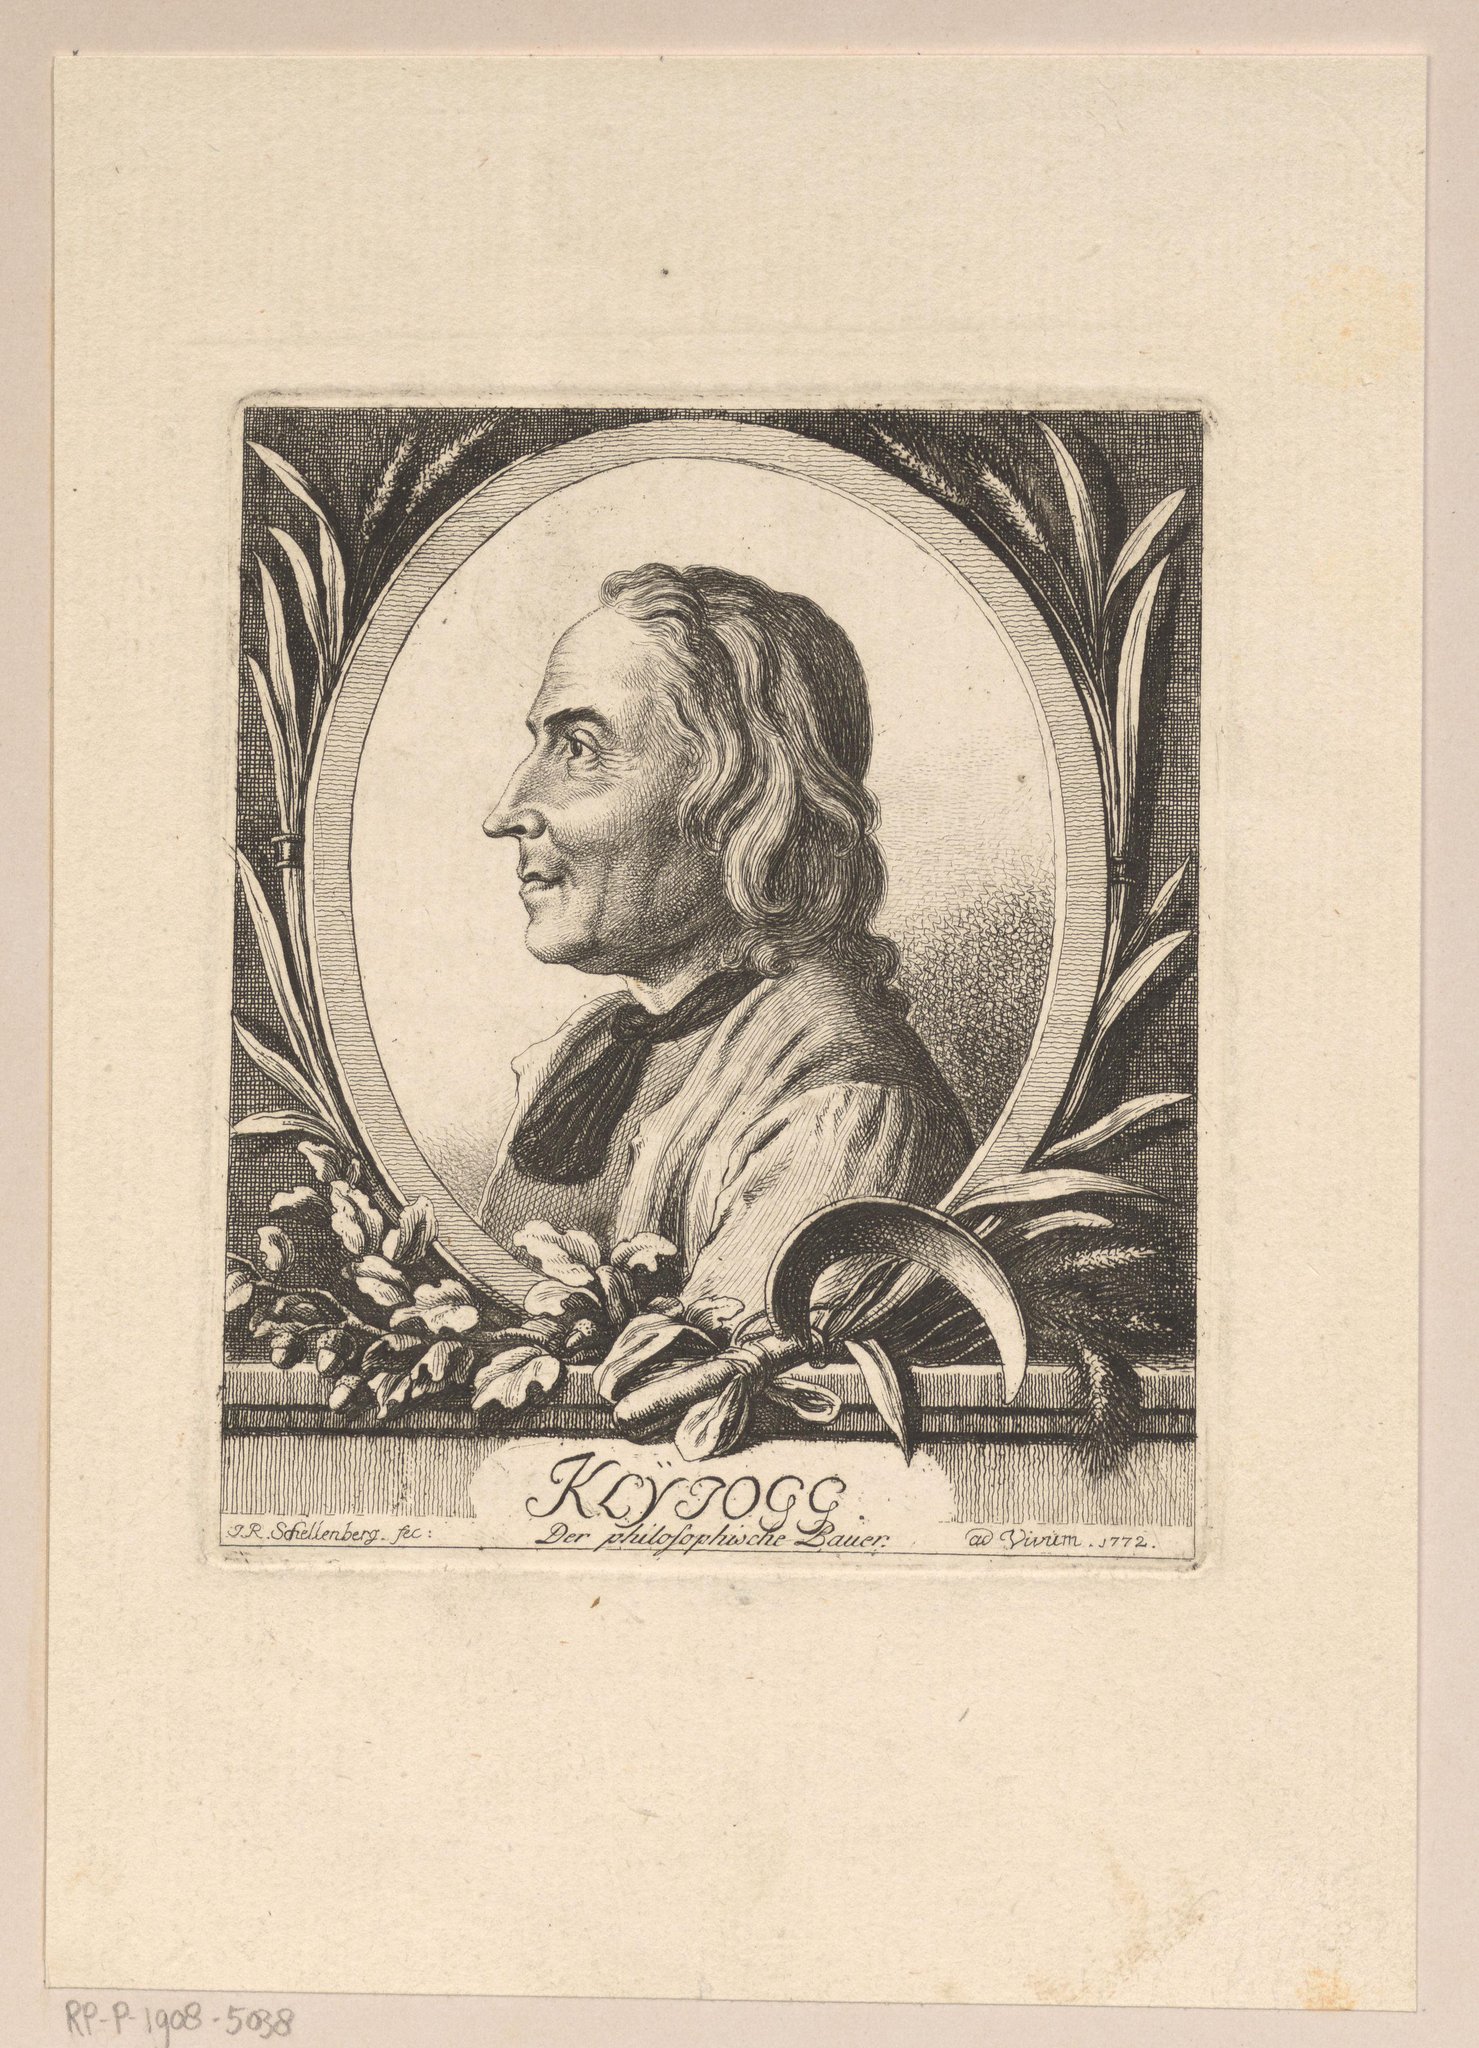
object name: print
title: Portret van Kleinjogg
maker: johann rudolph schellenberg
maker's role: print maker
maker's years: 1740-1806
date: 1772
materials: paper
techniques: etching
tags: switzerland, scholar, philosopher, historical persons, agricultural implements: sickle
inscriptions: collector's mark: Lugt 2228